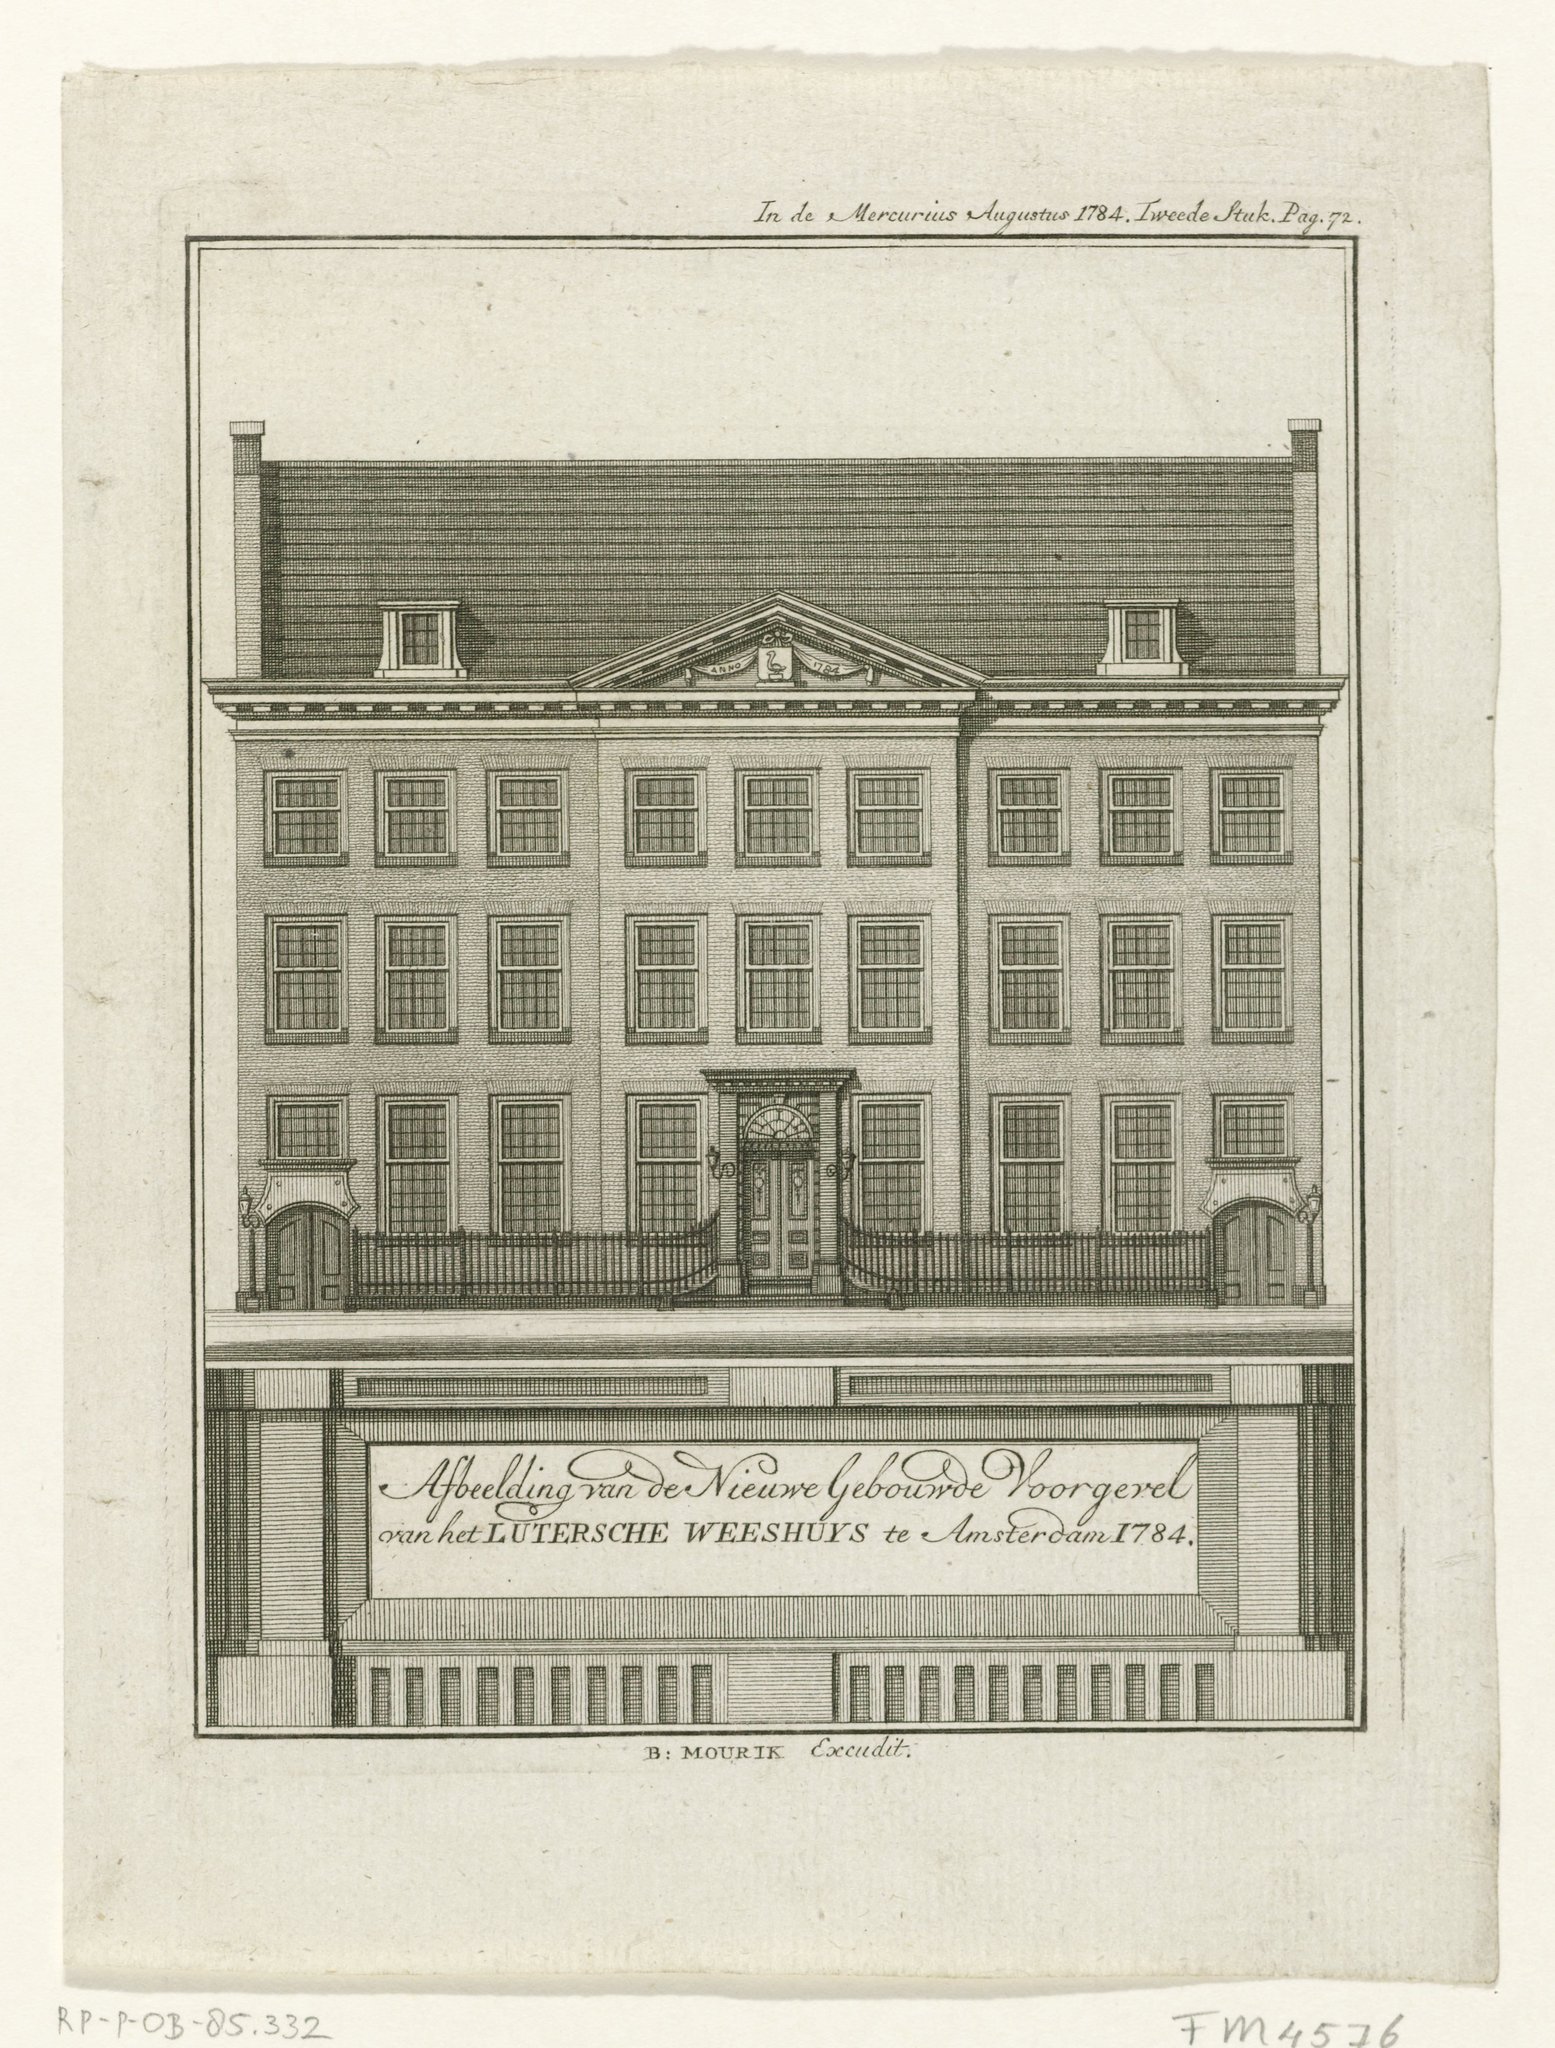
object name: print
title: Nieuwe voorgevel van het Lutherse Diaconie Weeshuis te Amsterdam, 1784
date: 1784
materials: paper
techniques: engraving, etching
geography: northern netherlands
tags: orphanage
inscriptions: collector's mark: Lugt 2228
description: Gebruikt als illustratie in: Maandelijkse Nederlandsche Mercurius, augustus 1784, tweede stuk, p. 72.